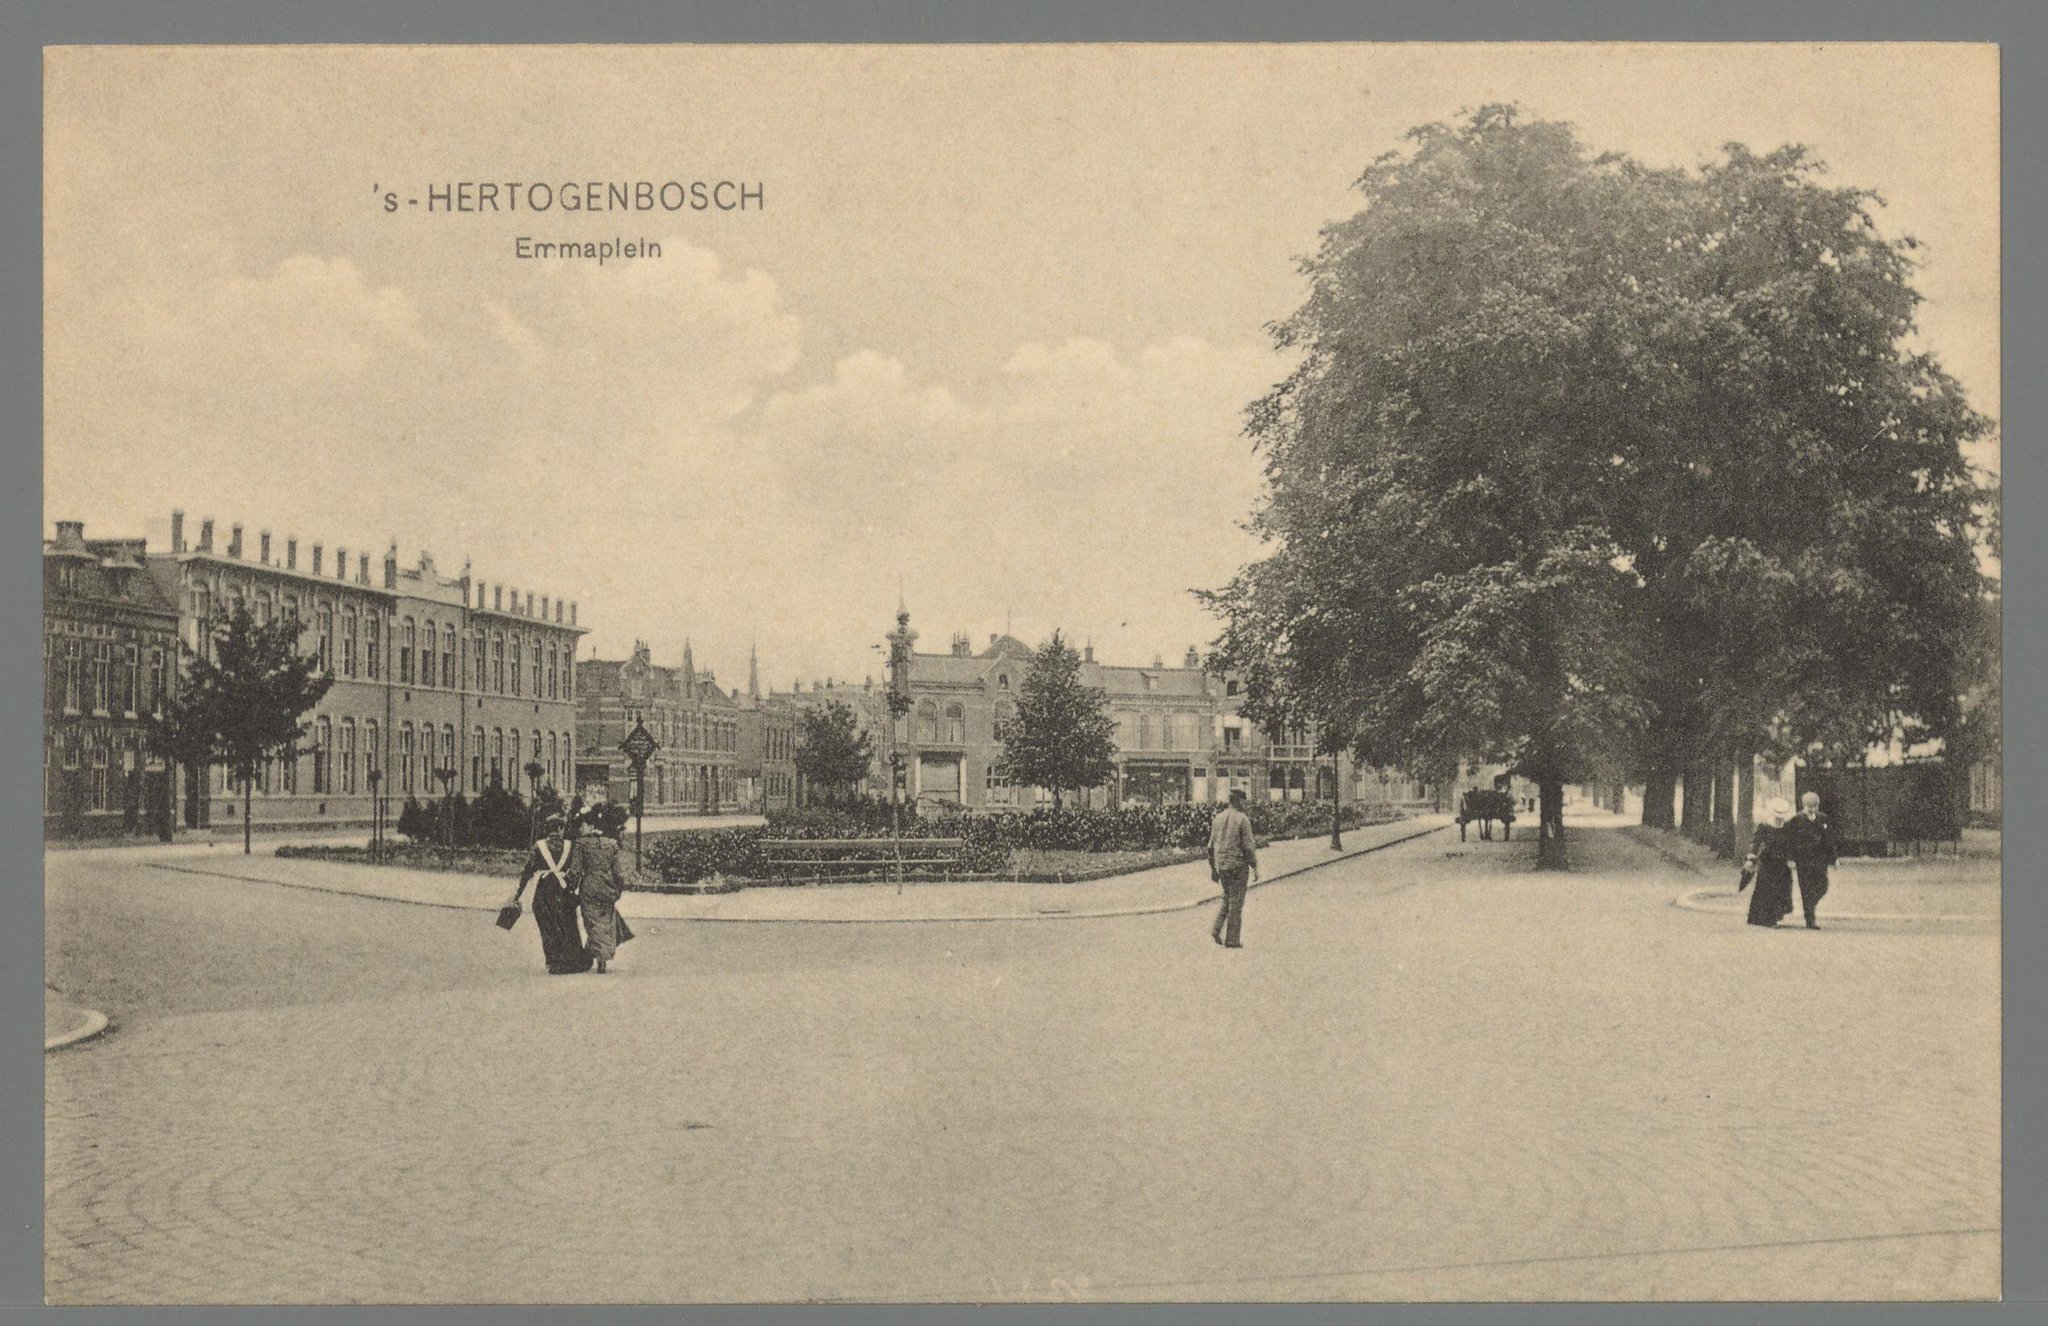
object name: ansichtkaart, prentbriefkaart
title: 's-Hertogenbosch. Emmaplein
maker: Anonymous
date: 1907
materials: cardboard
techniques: photograph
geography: den bosch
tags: square, place, circus, etc., den bosch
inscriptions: date